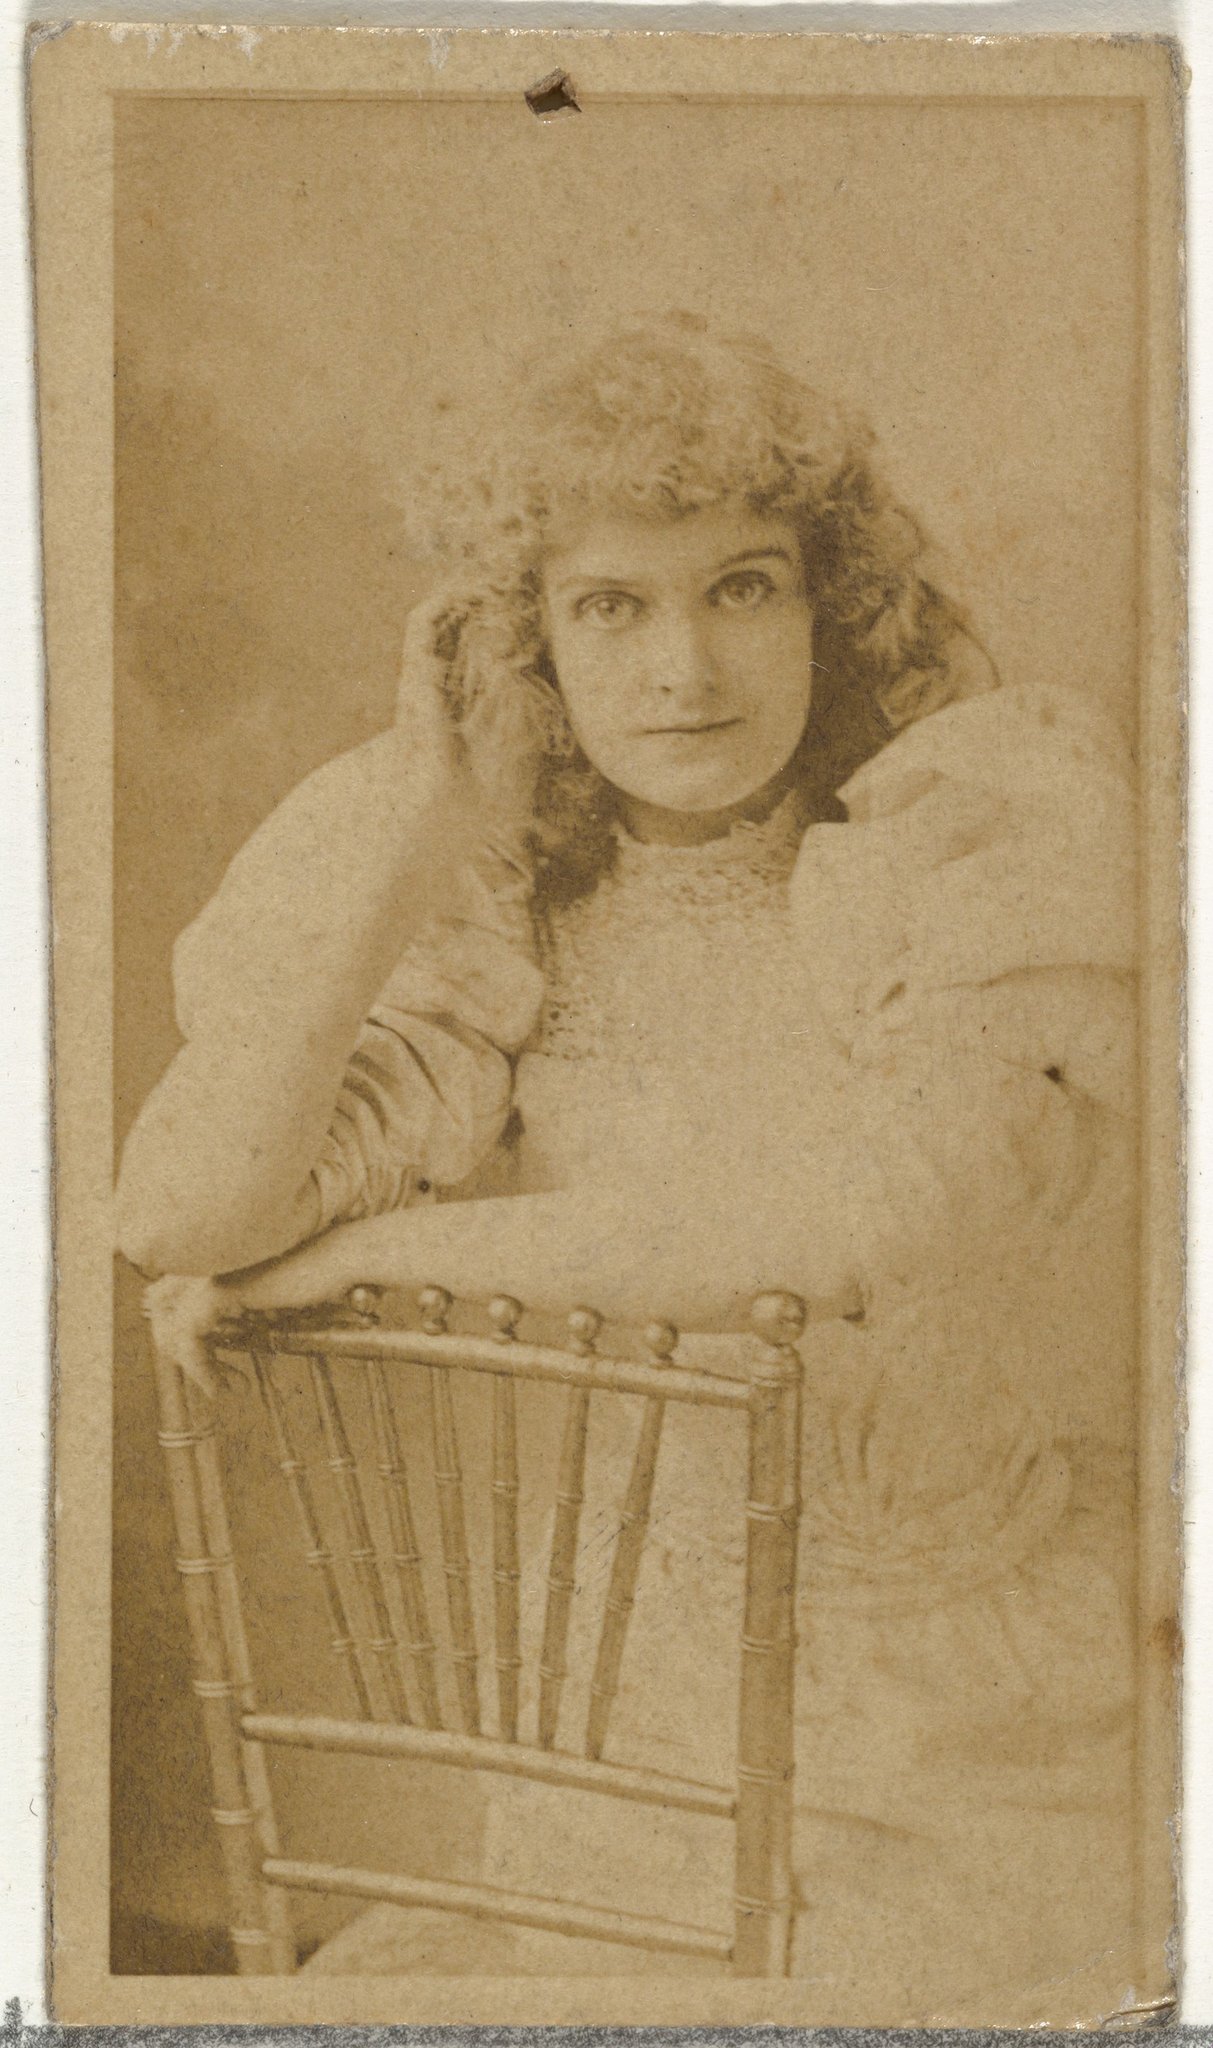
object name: photograph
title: [Actress posing on chair], from the Actors and Actresses series (N145-8) issued by Duke Sons & Co. to promote Duke Cigarettes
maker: w. duke, sons & co.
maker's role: publisher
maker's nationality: american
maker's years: 1870-1920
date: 1891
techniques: albumen silver print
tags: portraits,women,actresses